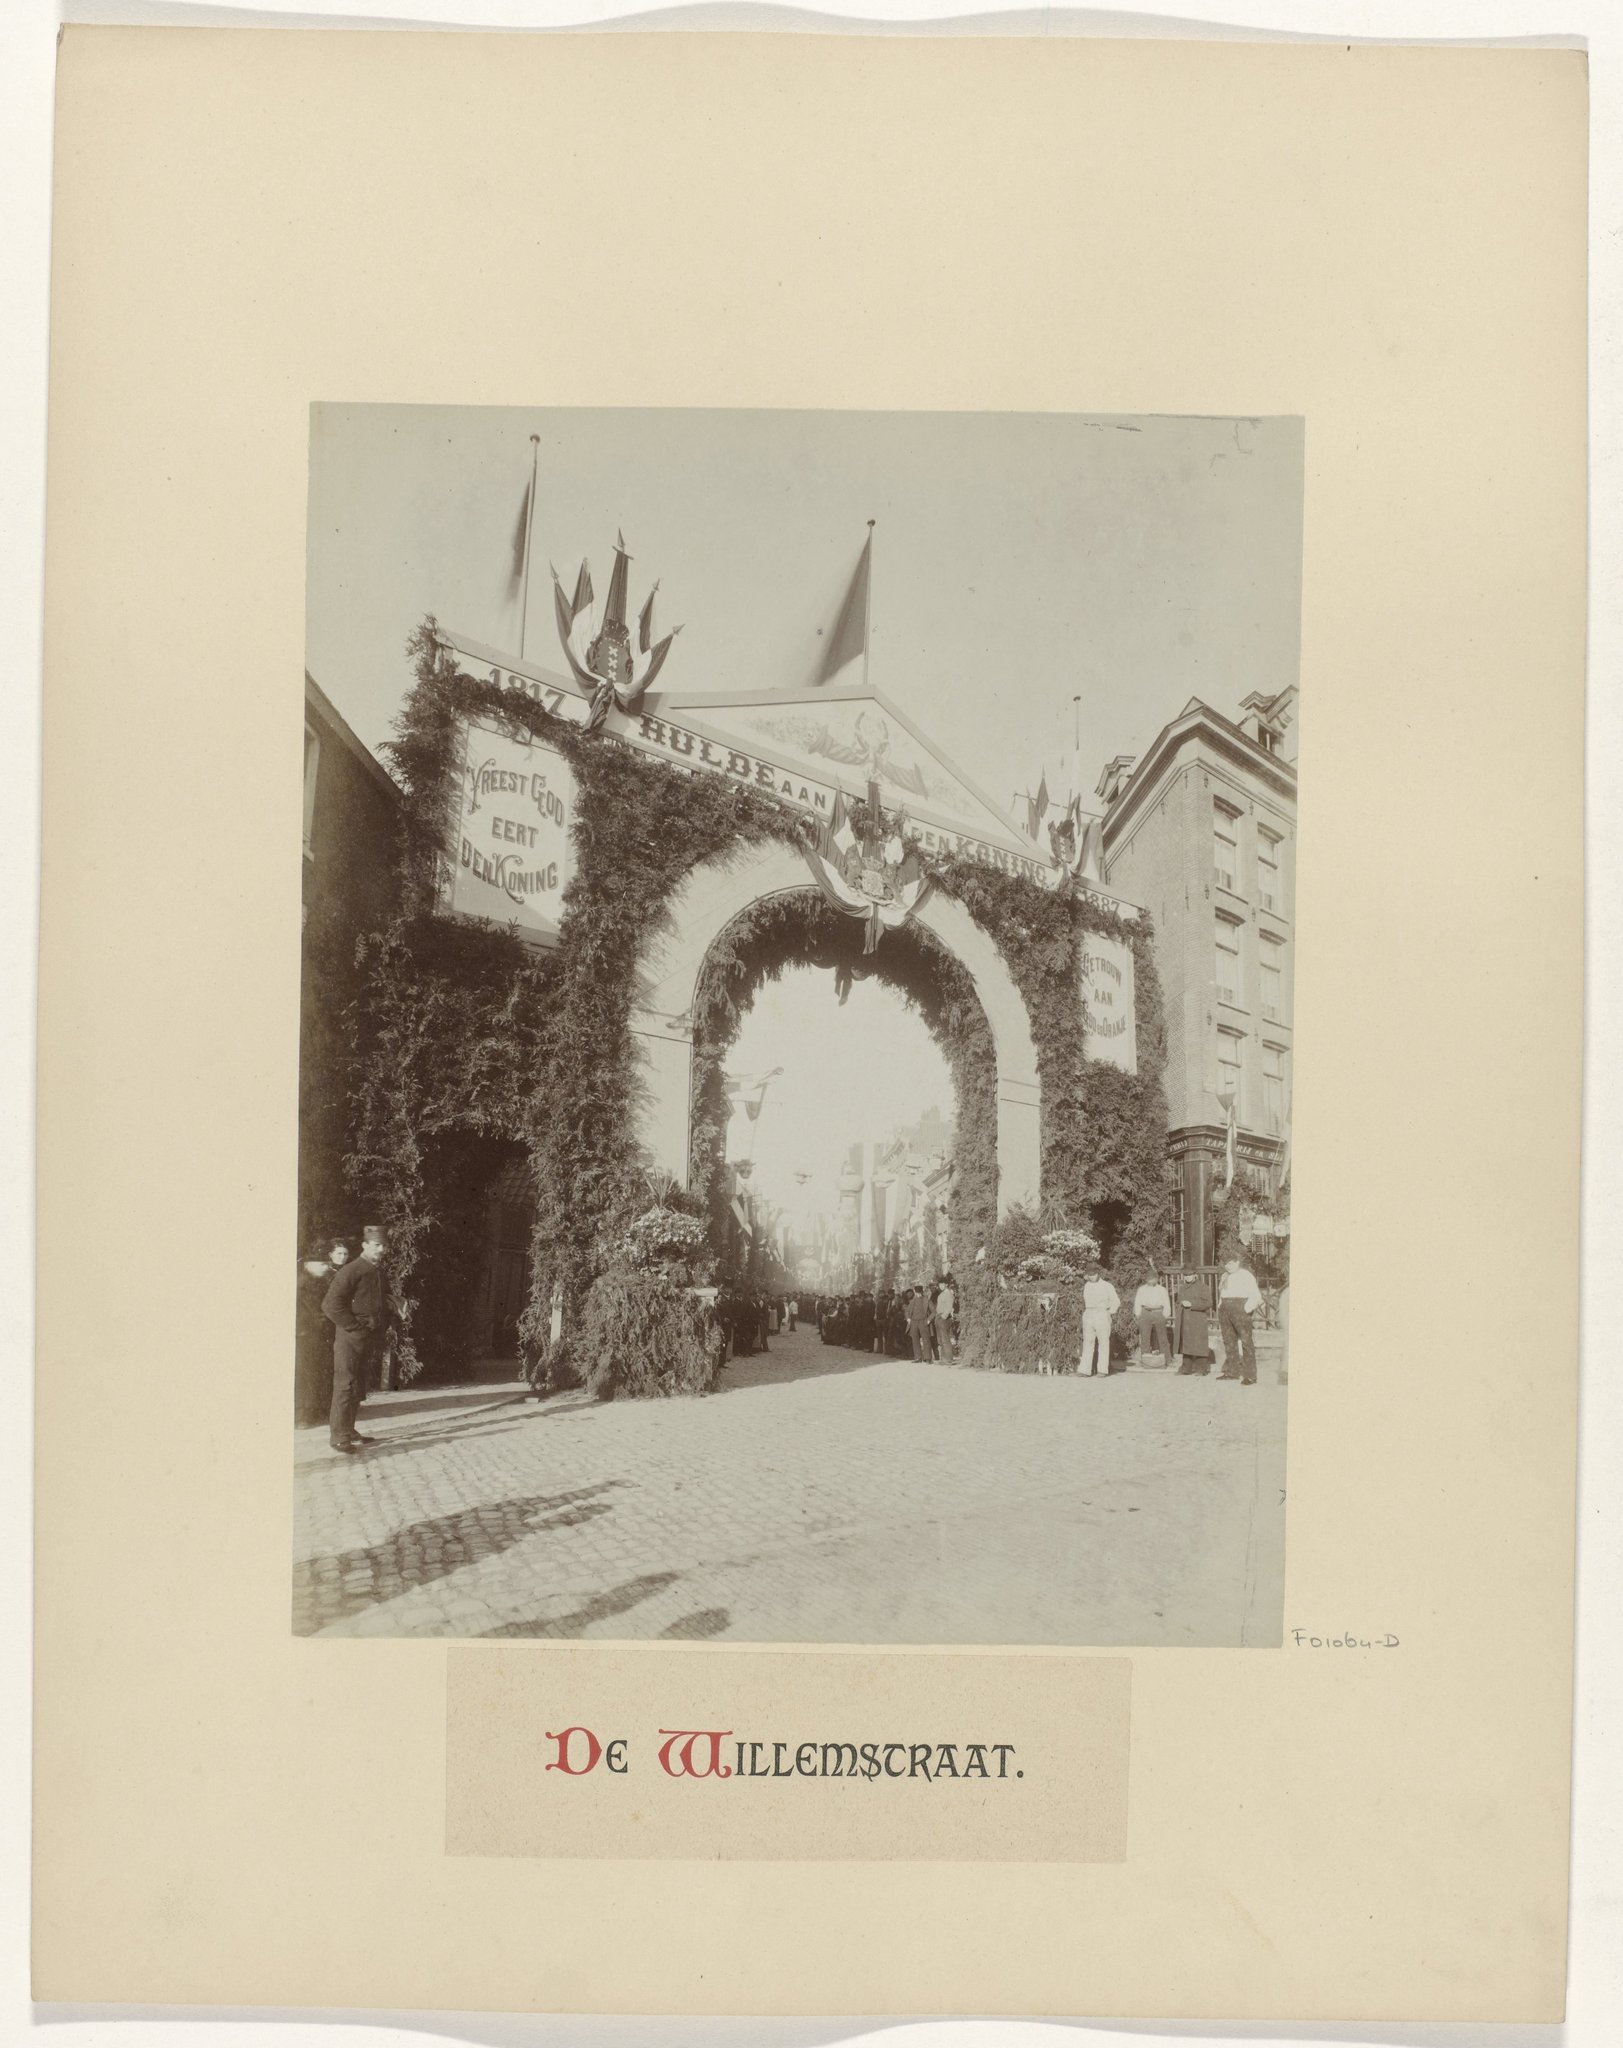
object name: photograph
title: Menigte in de Willemstraat tijdens de Aprilfeesten van 1887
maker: henri de louw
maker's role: fotograaf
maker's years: 1851-1944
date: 1887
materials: paper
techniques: albumen print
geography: amsterdam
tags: public festivities, public road, amsterdam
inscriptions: inscription: ‘De Willemstraat’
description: Deze foto maakt deel uit van een omslag met twaalf foto's.